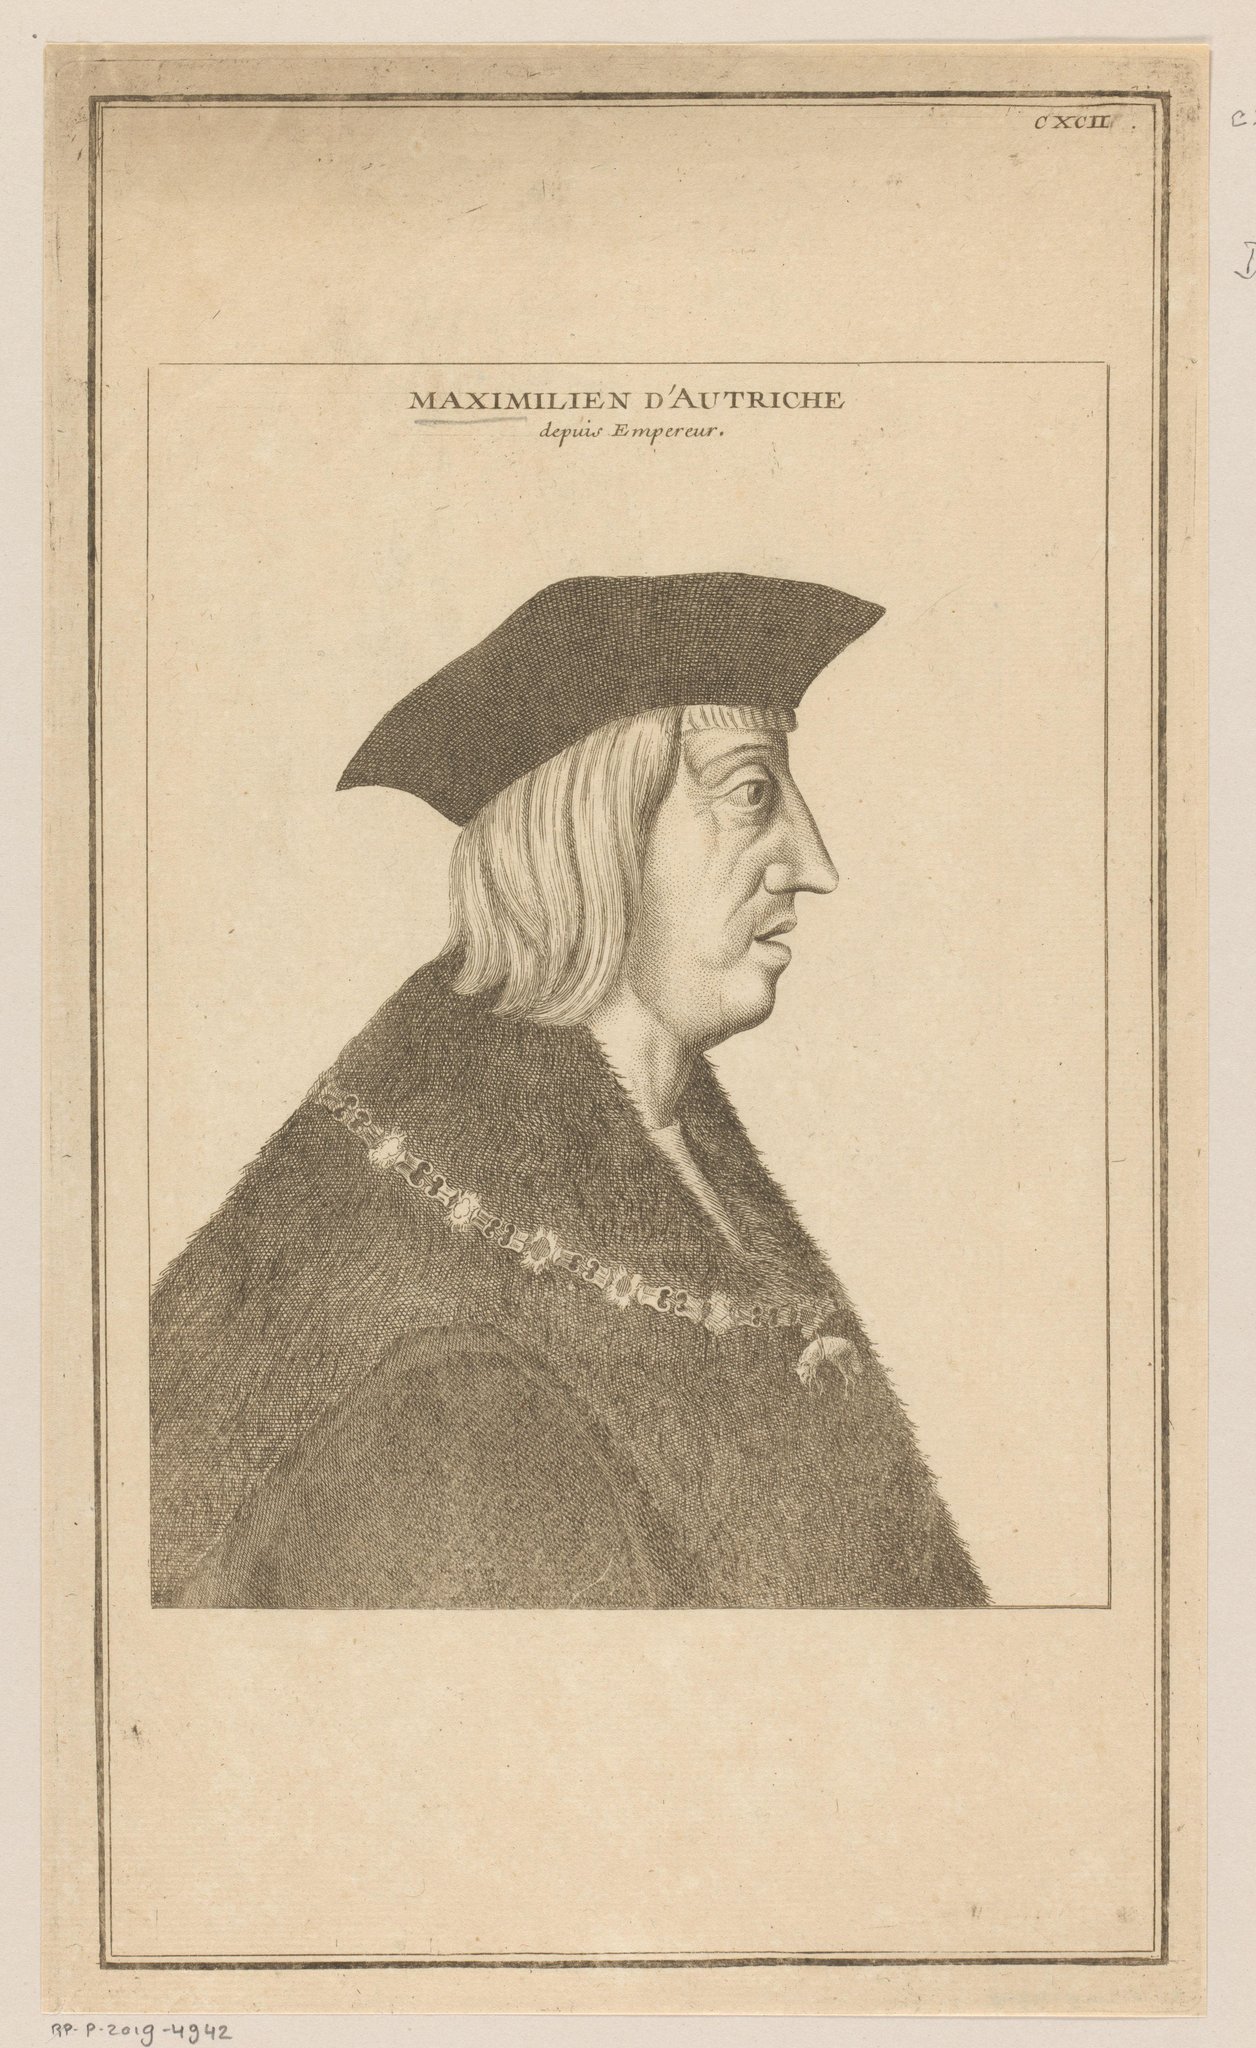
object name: book illustration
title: Portret van keizer Maximiliaan I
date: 1750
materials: paper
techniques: etching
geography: london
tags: maximilian i (holy roman emperor), historical persons, emperor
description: Prent uit: Montfaucon, Bernard de. A collection of regal and ecclesiastical antiquities of France (...). Londen: William Innys, John en Paul Knapton, R. Manby en Henry Shute Cox, 1750, dl. 2. Prent voor het eerst, met andere nummering, verschenen in: Montfaucon, Bernard de. Les monumens de la Monarchie Françoise (...). Parijs: Julien-Michel Gandouin en Pierre-François Giffart, 1729-1733.